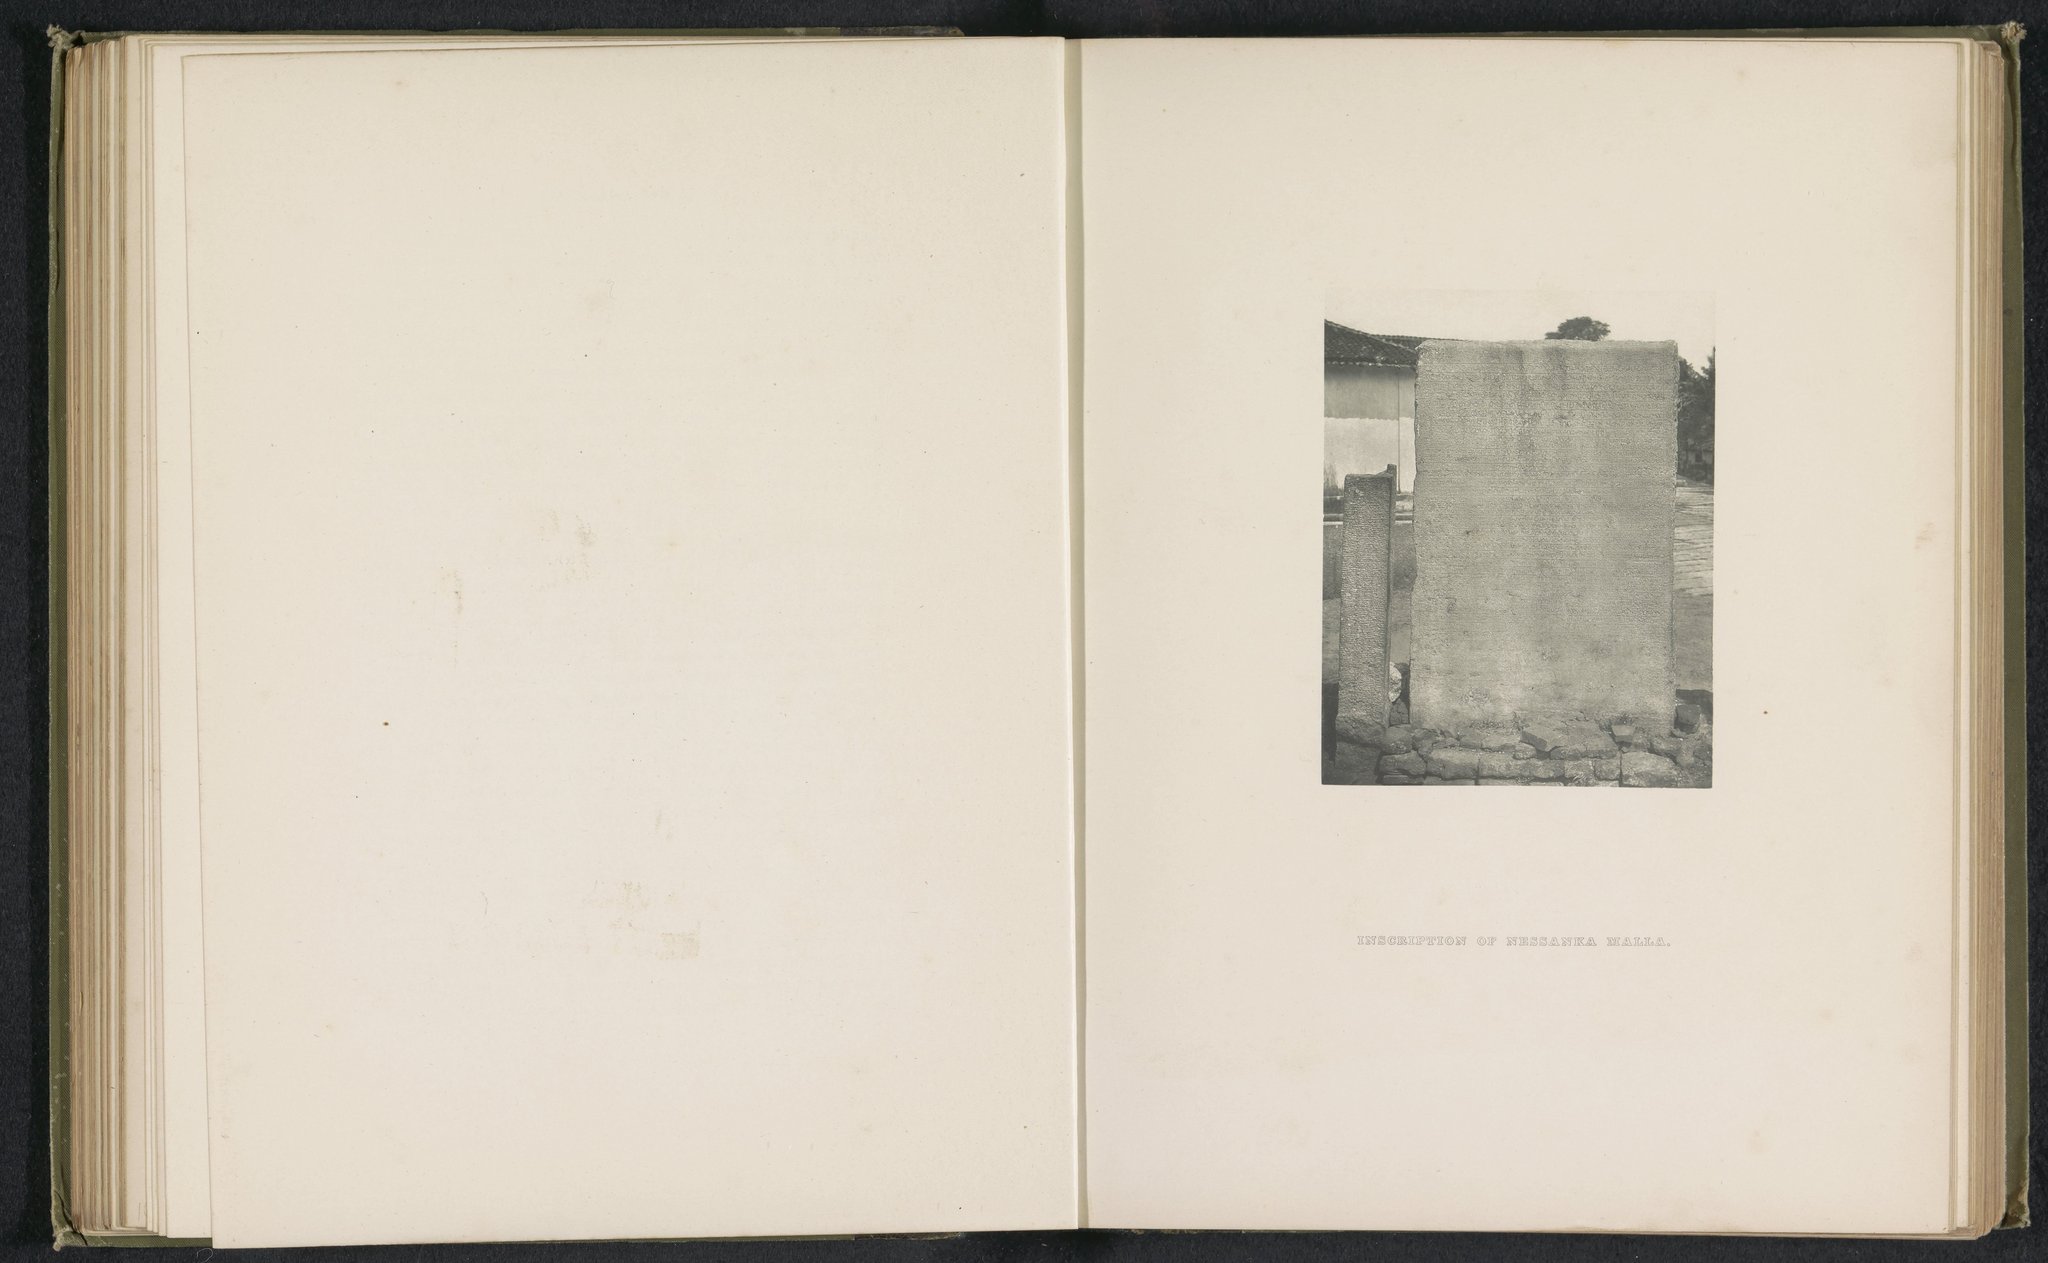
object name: photomechanical print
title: Inscription in the Ruwanwelisaya stupa complex at Anuradhapura, Sri Lanka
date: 1896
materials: paper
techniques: woodburygravure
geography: anuradhapura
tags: inscription, places and objects of worship ~ hinduism, buddhism, jainism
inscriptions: title: ‘INSCRIPTION OF NESSANKA MALLA.’